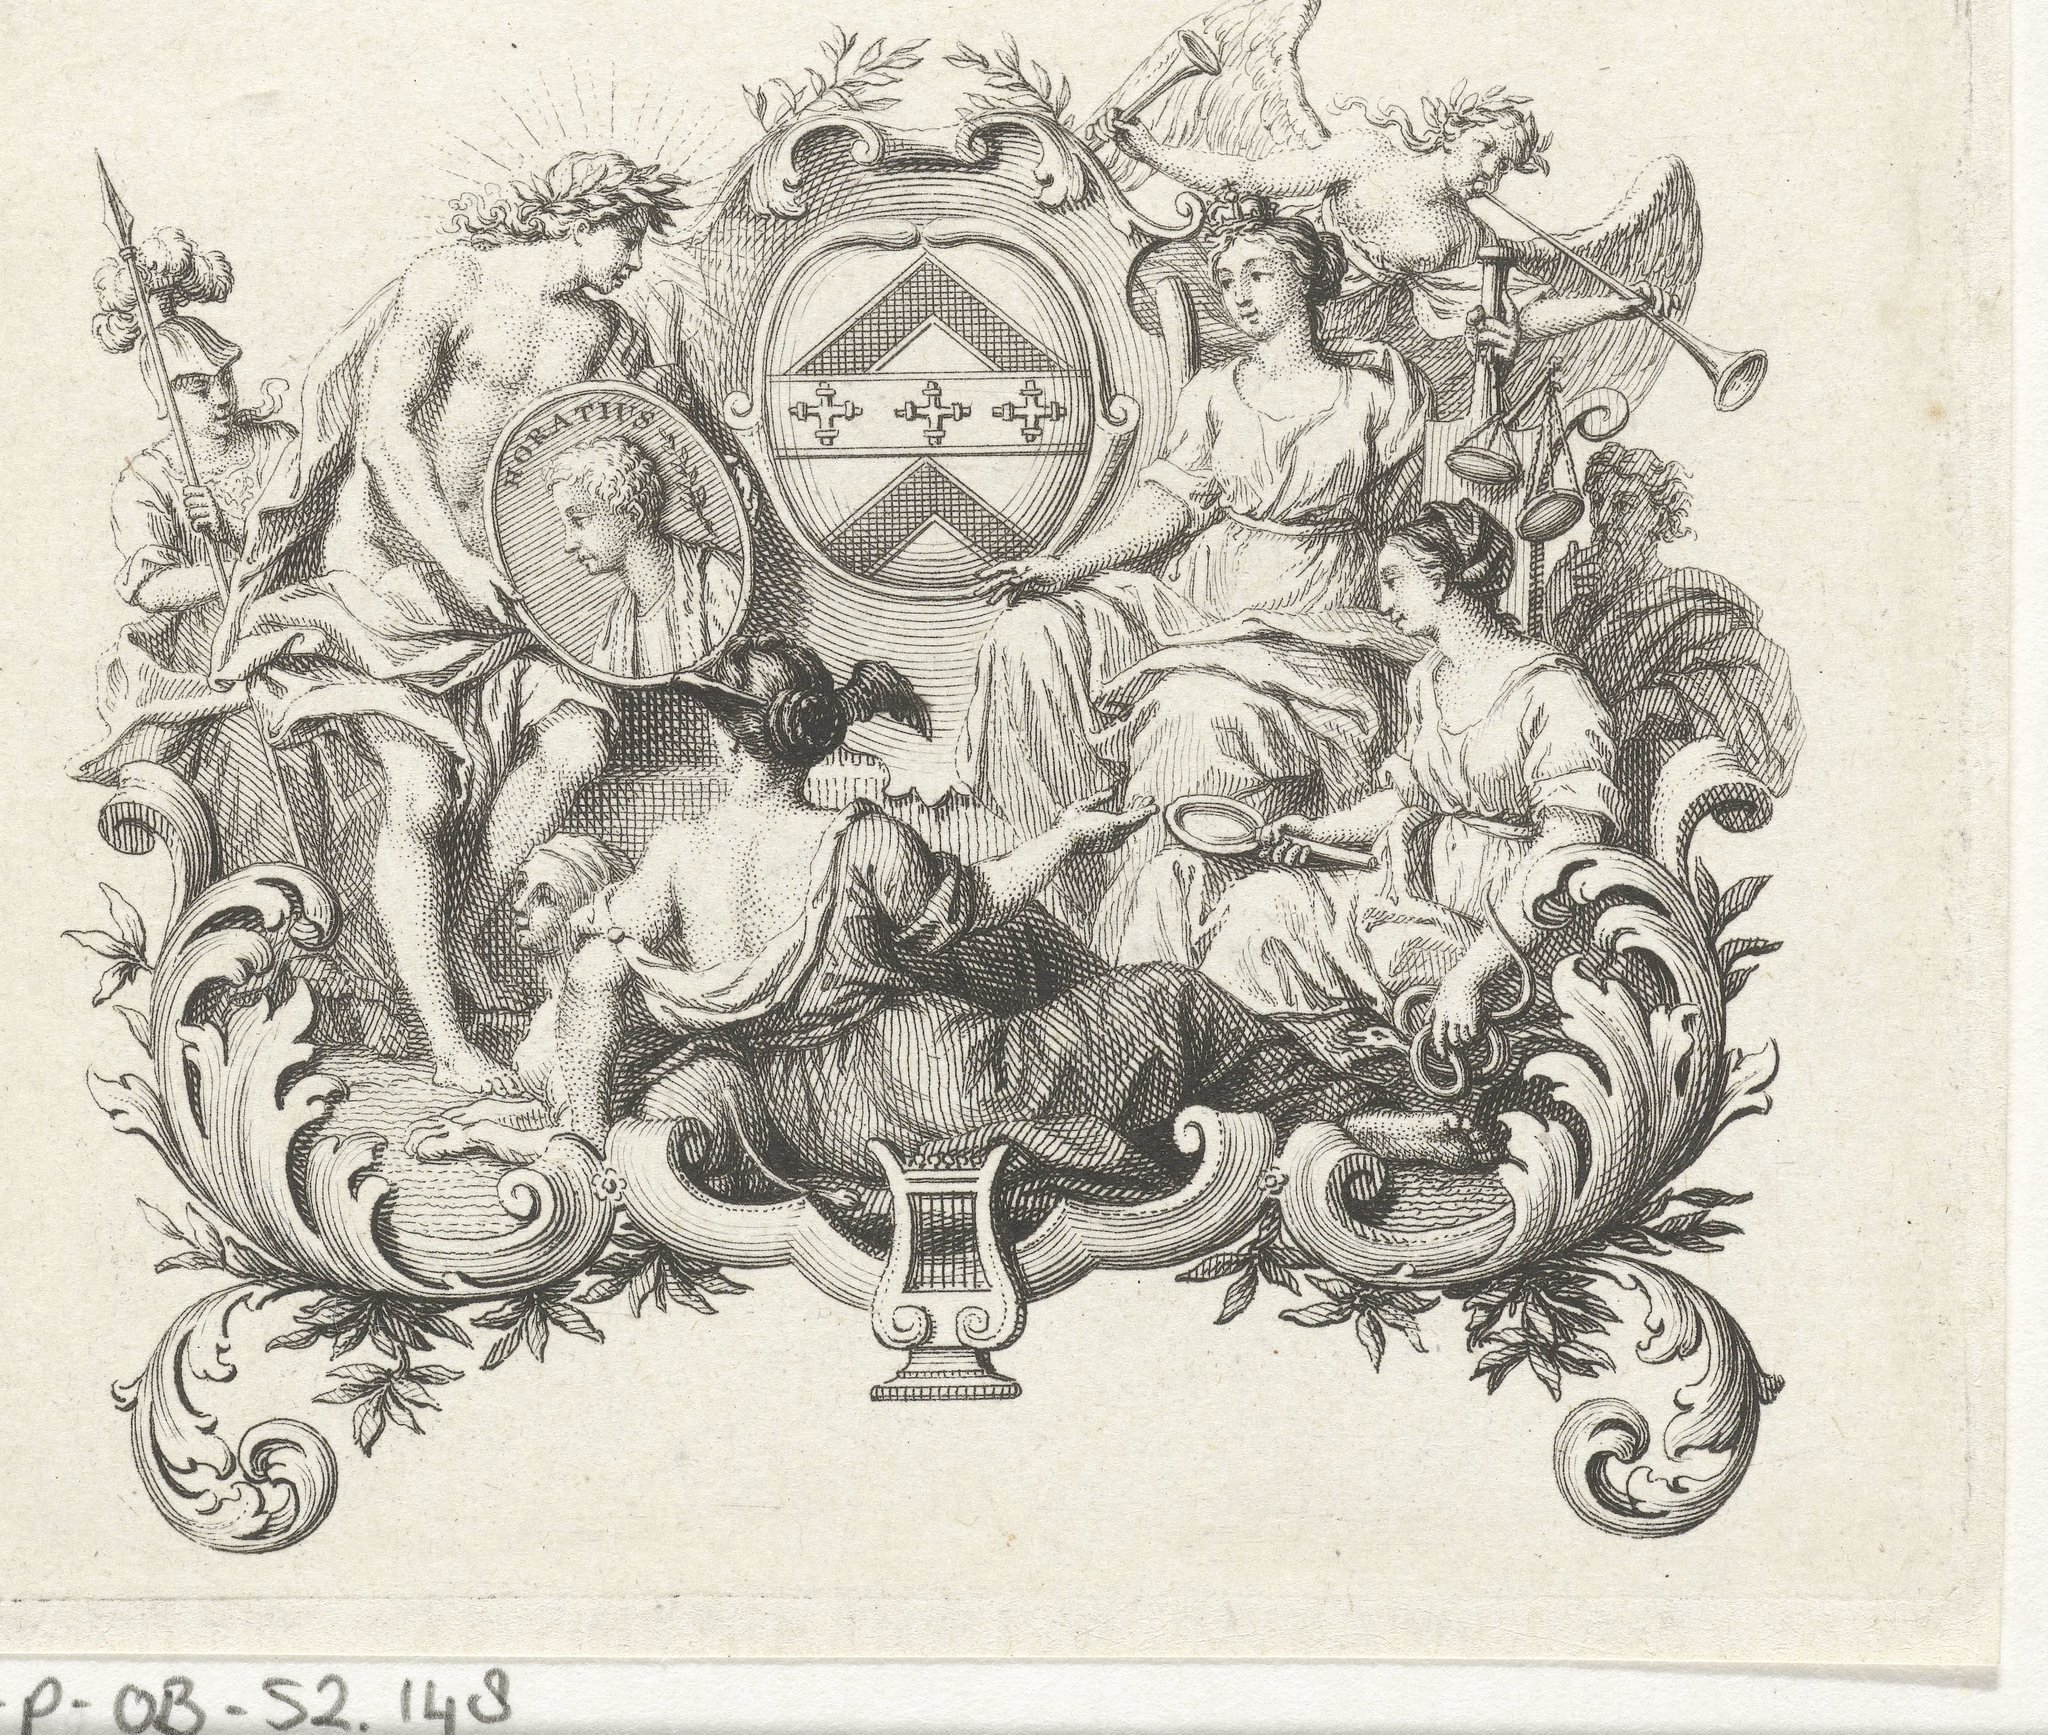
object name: print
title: Cartouche met portretmedaillon van Horatius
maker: jacob folkema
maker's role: draughtsman, print maker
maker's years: 1692-1767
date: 1702-1767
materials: paper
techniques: etching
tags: (story of) apollo (phoebus)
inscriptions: collector's mark: Lugt 240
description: Naast een wapenschild, opgenomen in een sierlijk vormgegeven cartouche, staat Apollo met een portretmedaillon van Horatius in zijn handen. Hij wordt vergezeld door diverse allegorische figuren.